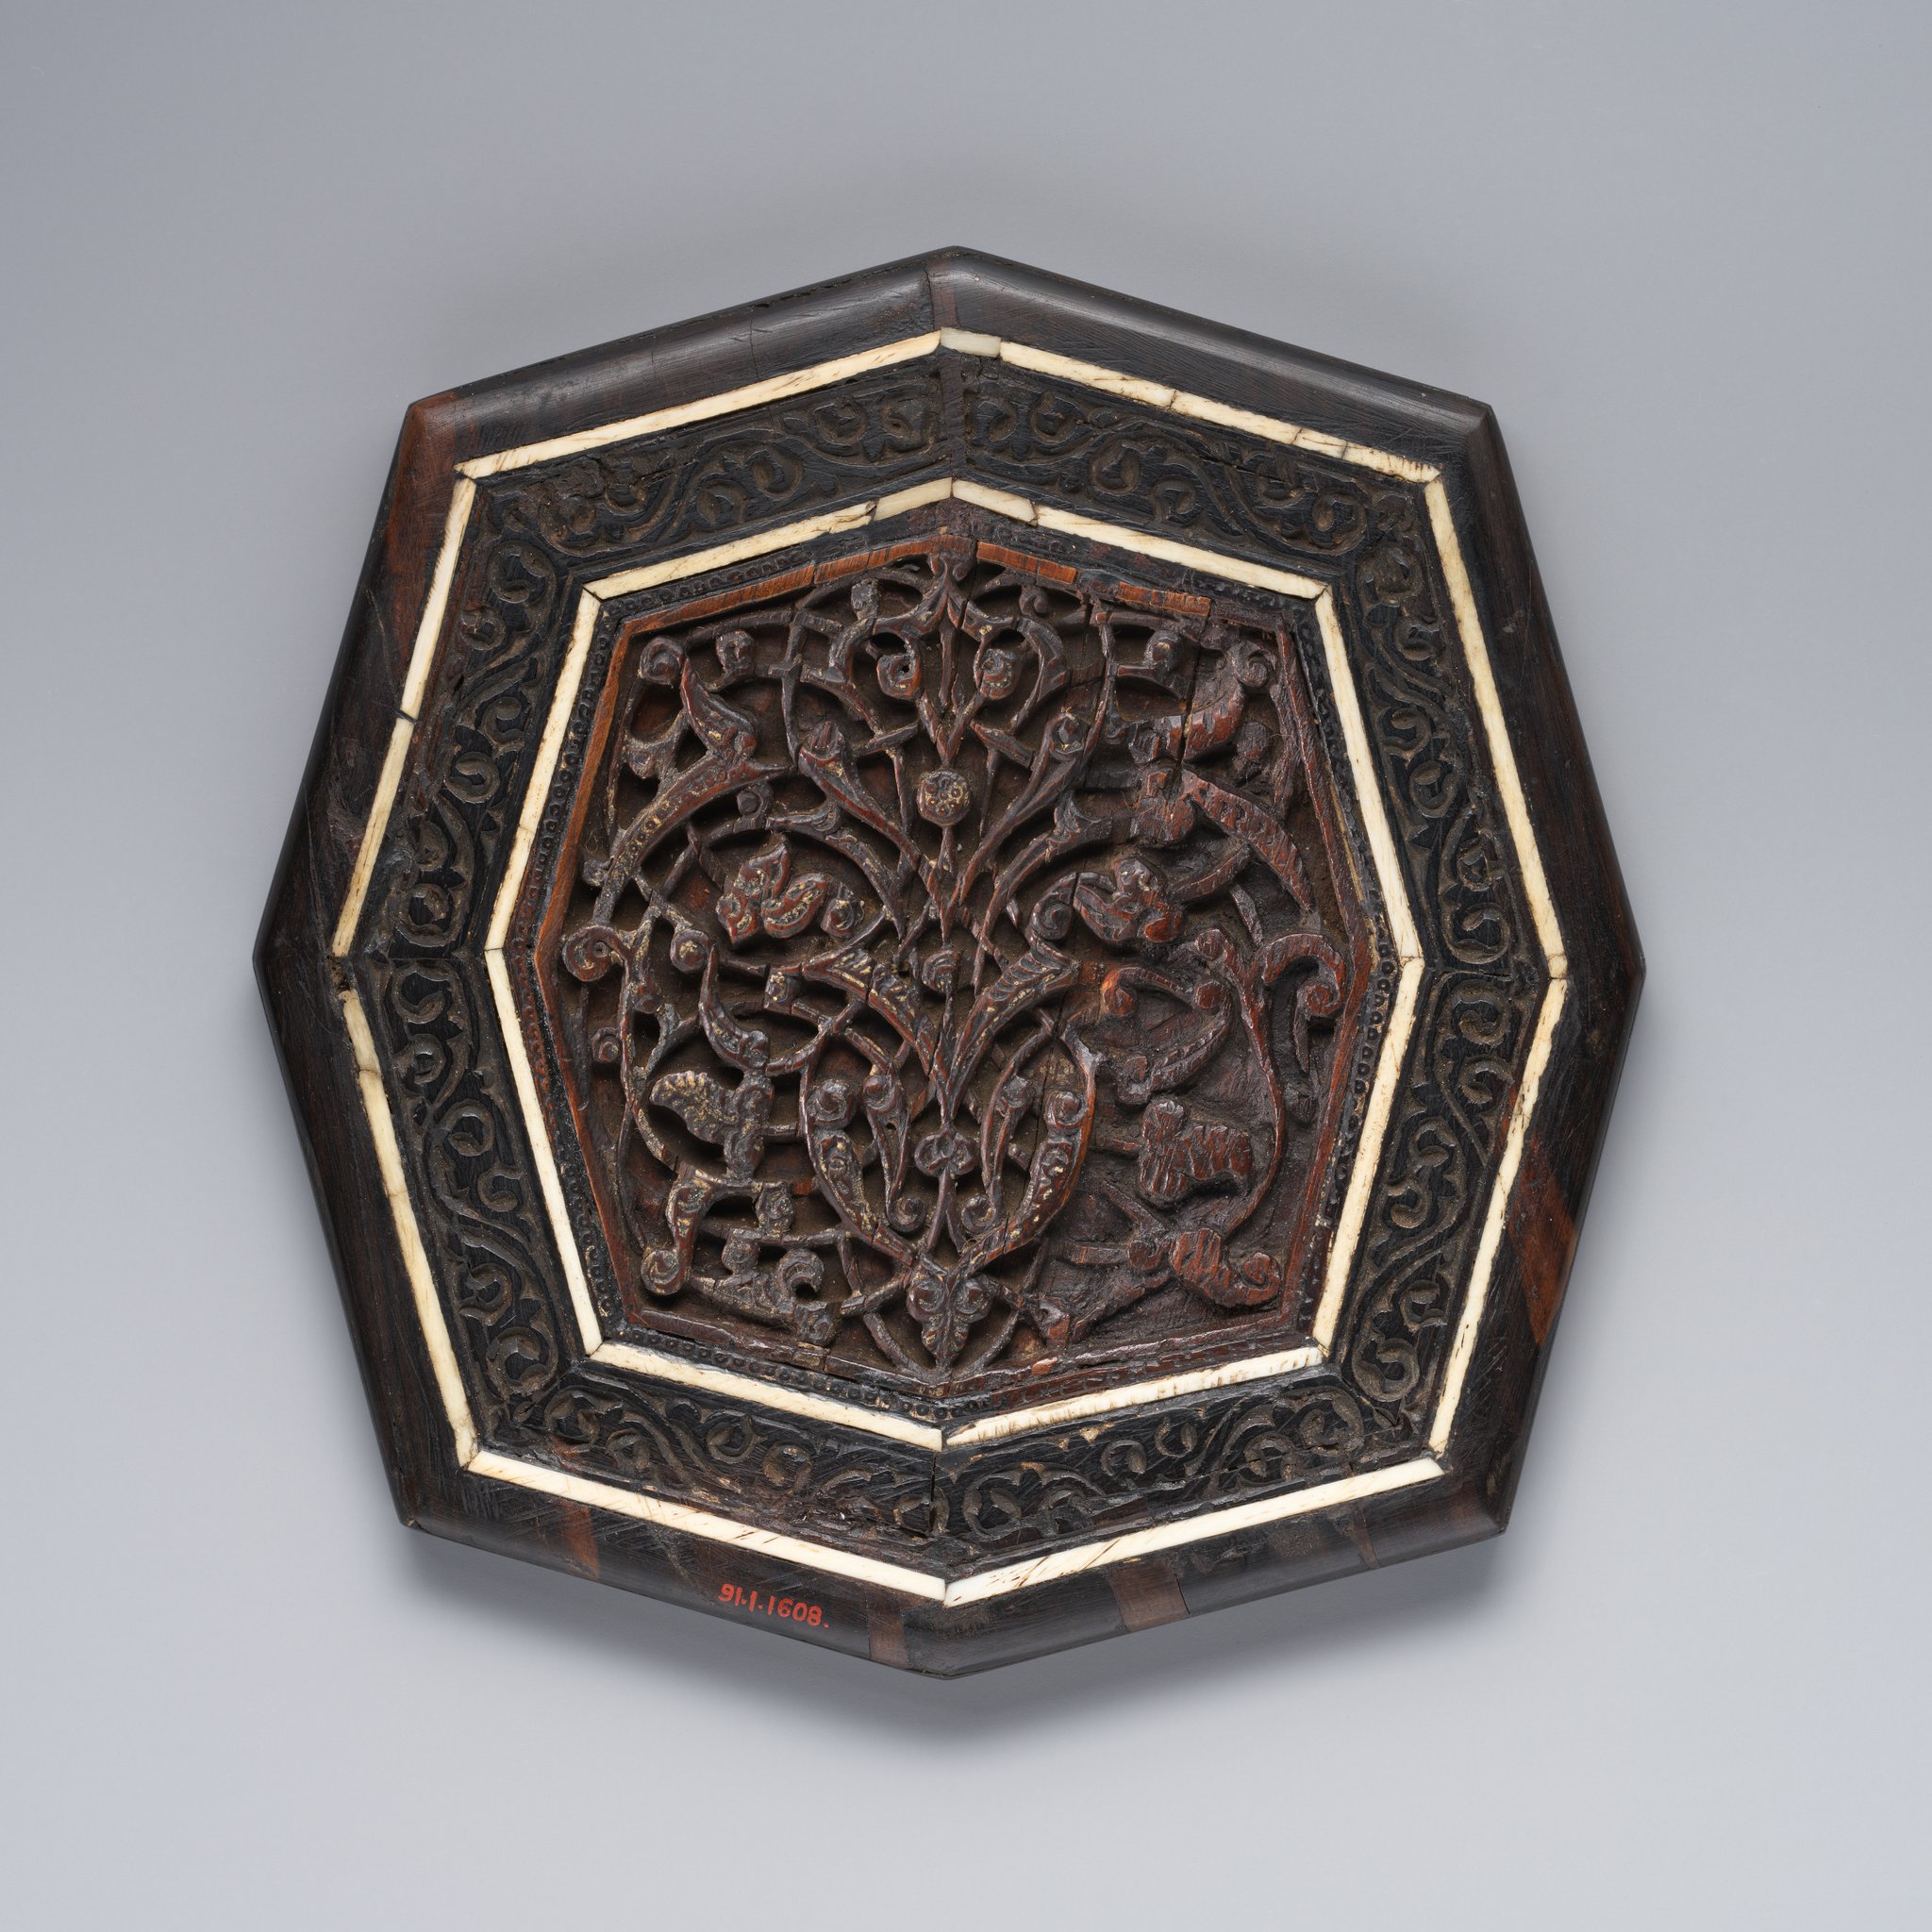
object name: panel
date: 1301-1500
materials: ivory, wood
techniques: carving, inlay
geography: egypt